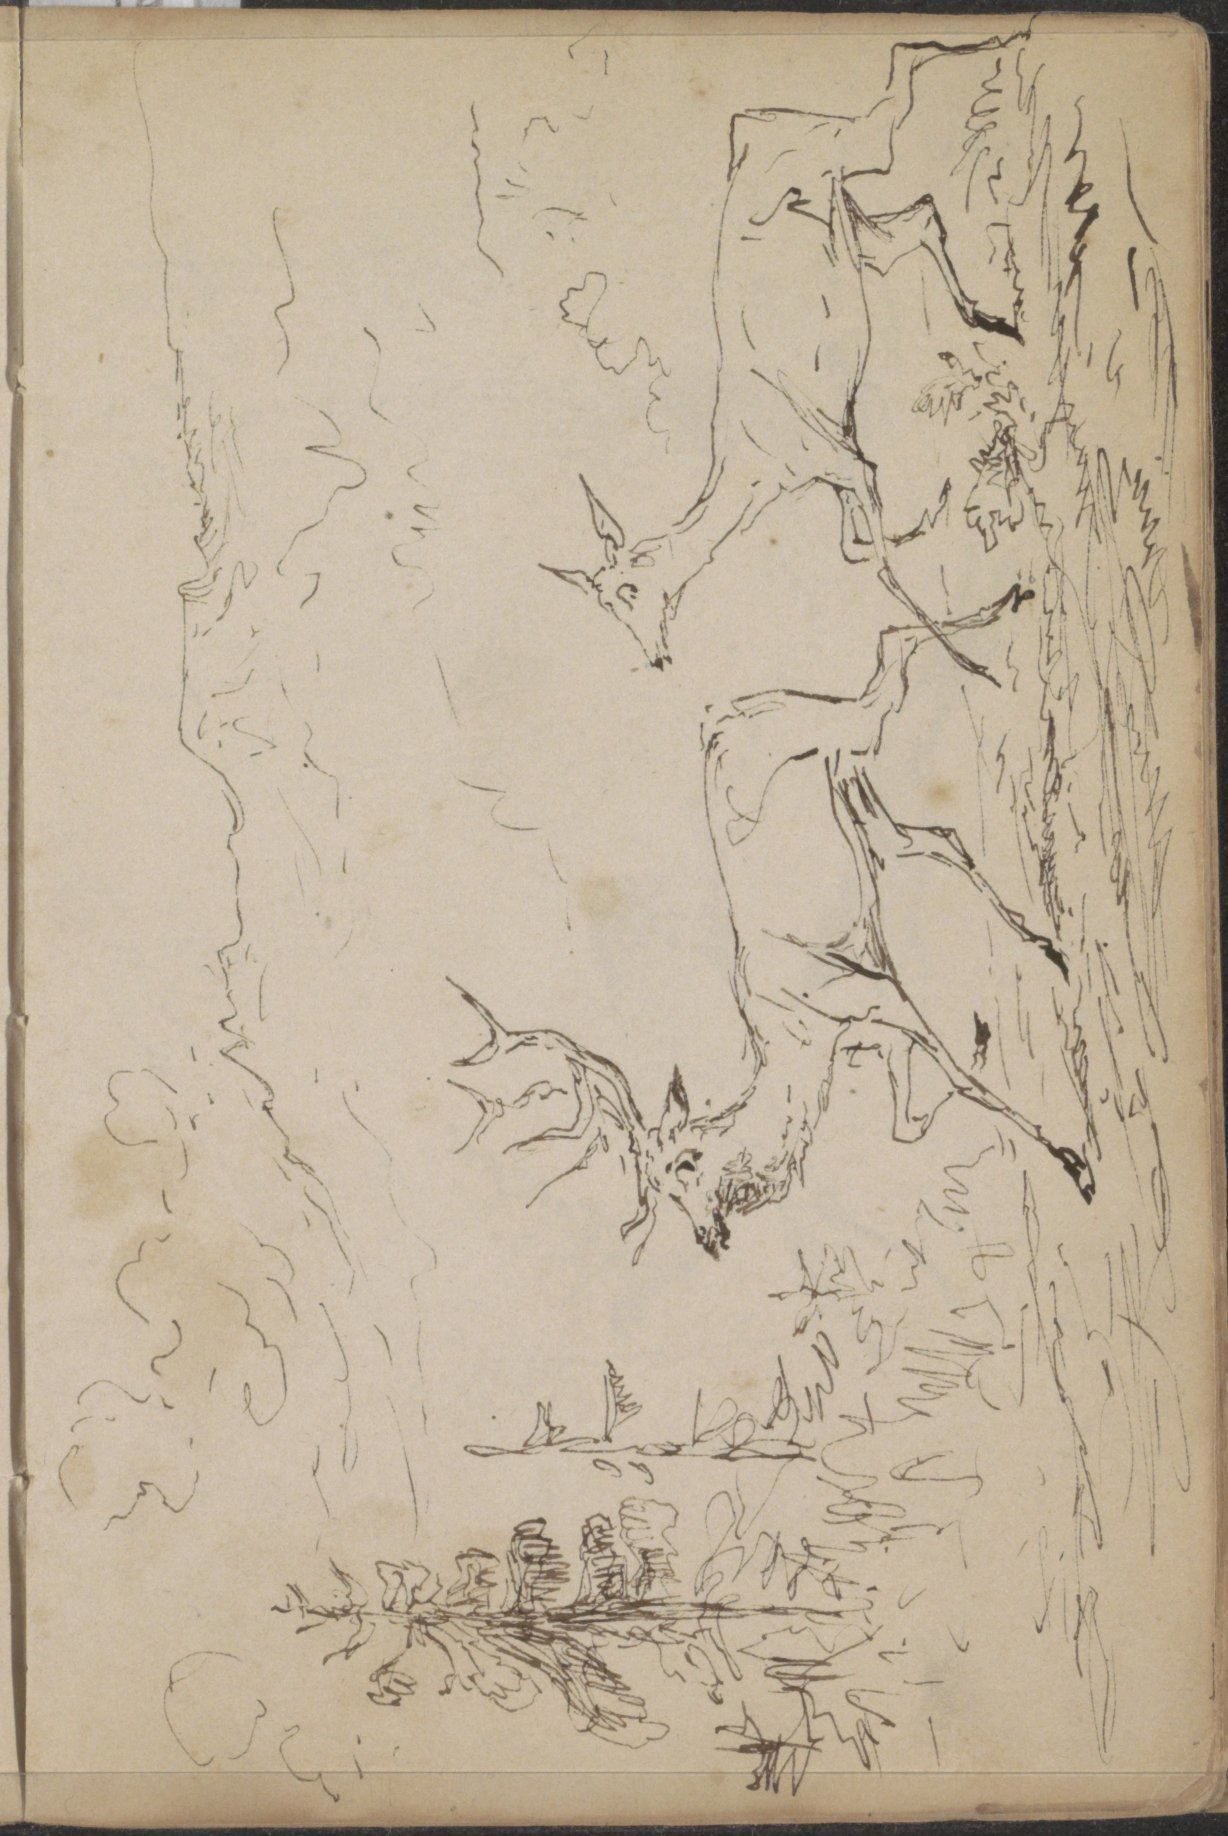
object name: sketchbook leaf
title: Twee herten in een berglandschap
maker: johannes tavenraat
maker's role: draughtsman, painter, print maker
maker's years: 1809-1881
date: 1858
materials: ink, paper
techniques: pen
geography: bohemia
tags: hoofed animals: deer, trees: fir, mountains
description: Blad 20 recto uit een schetsboek met 44 bladen.